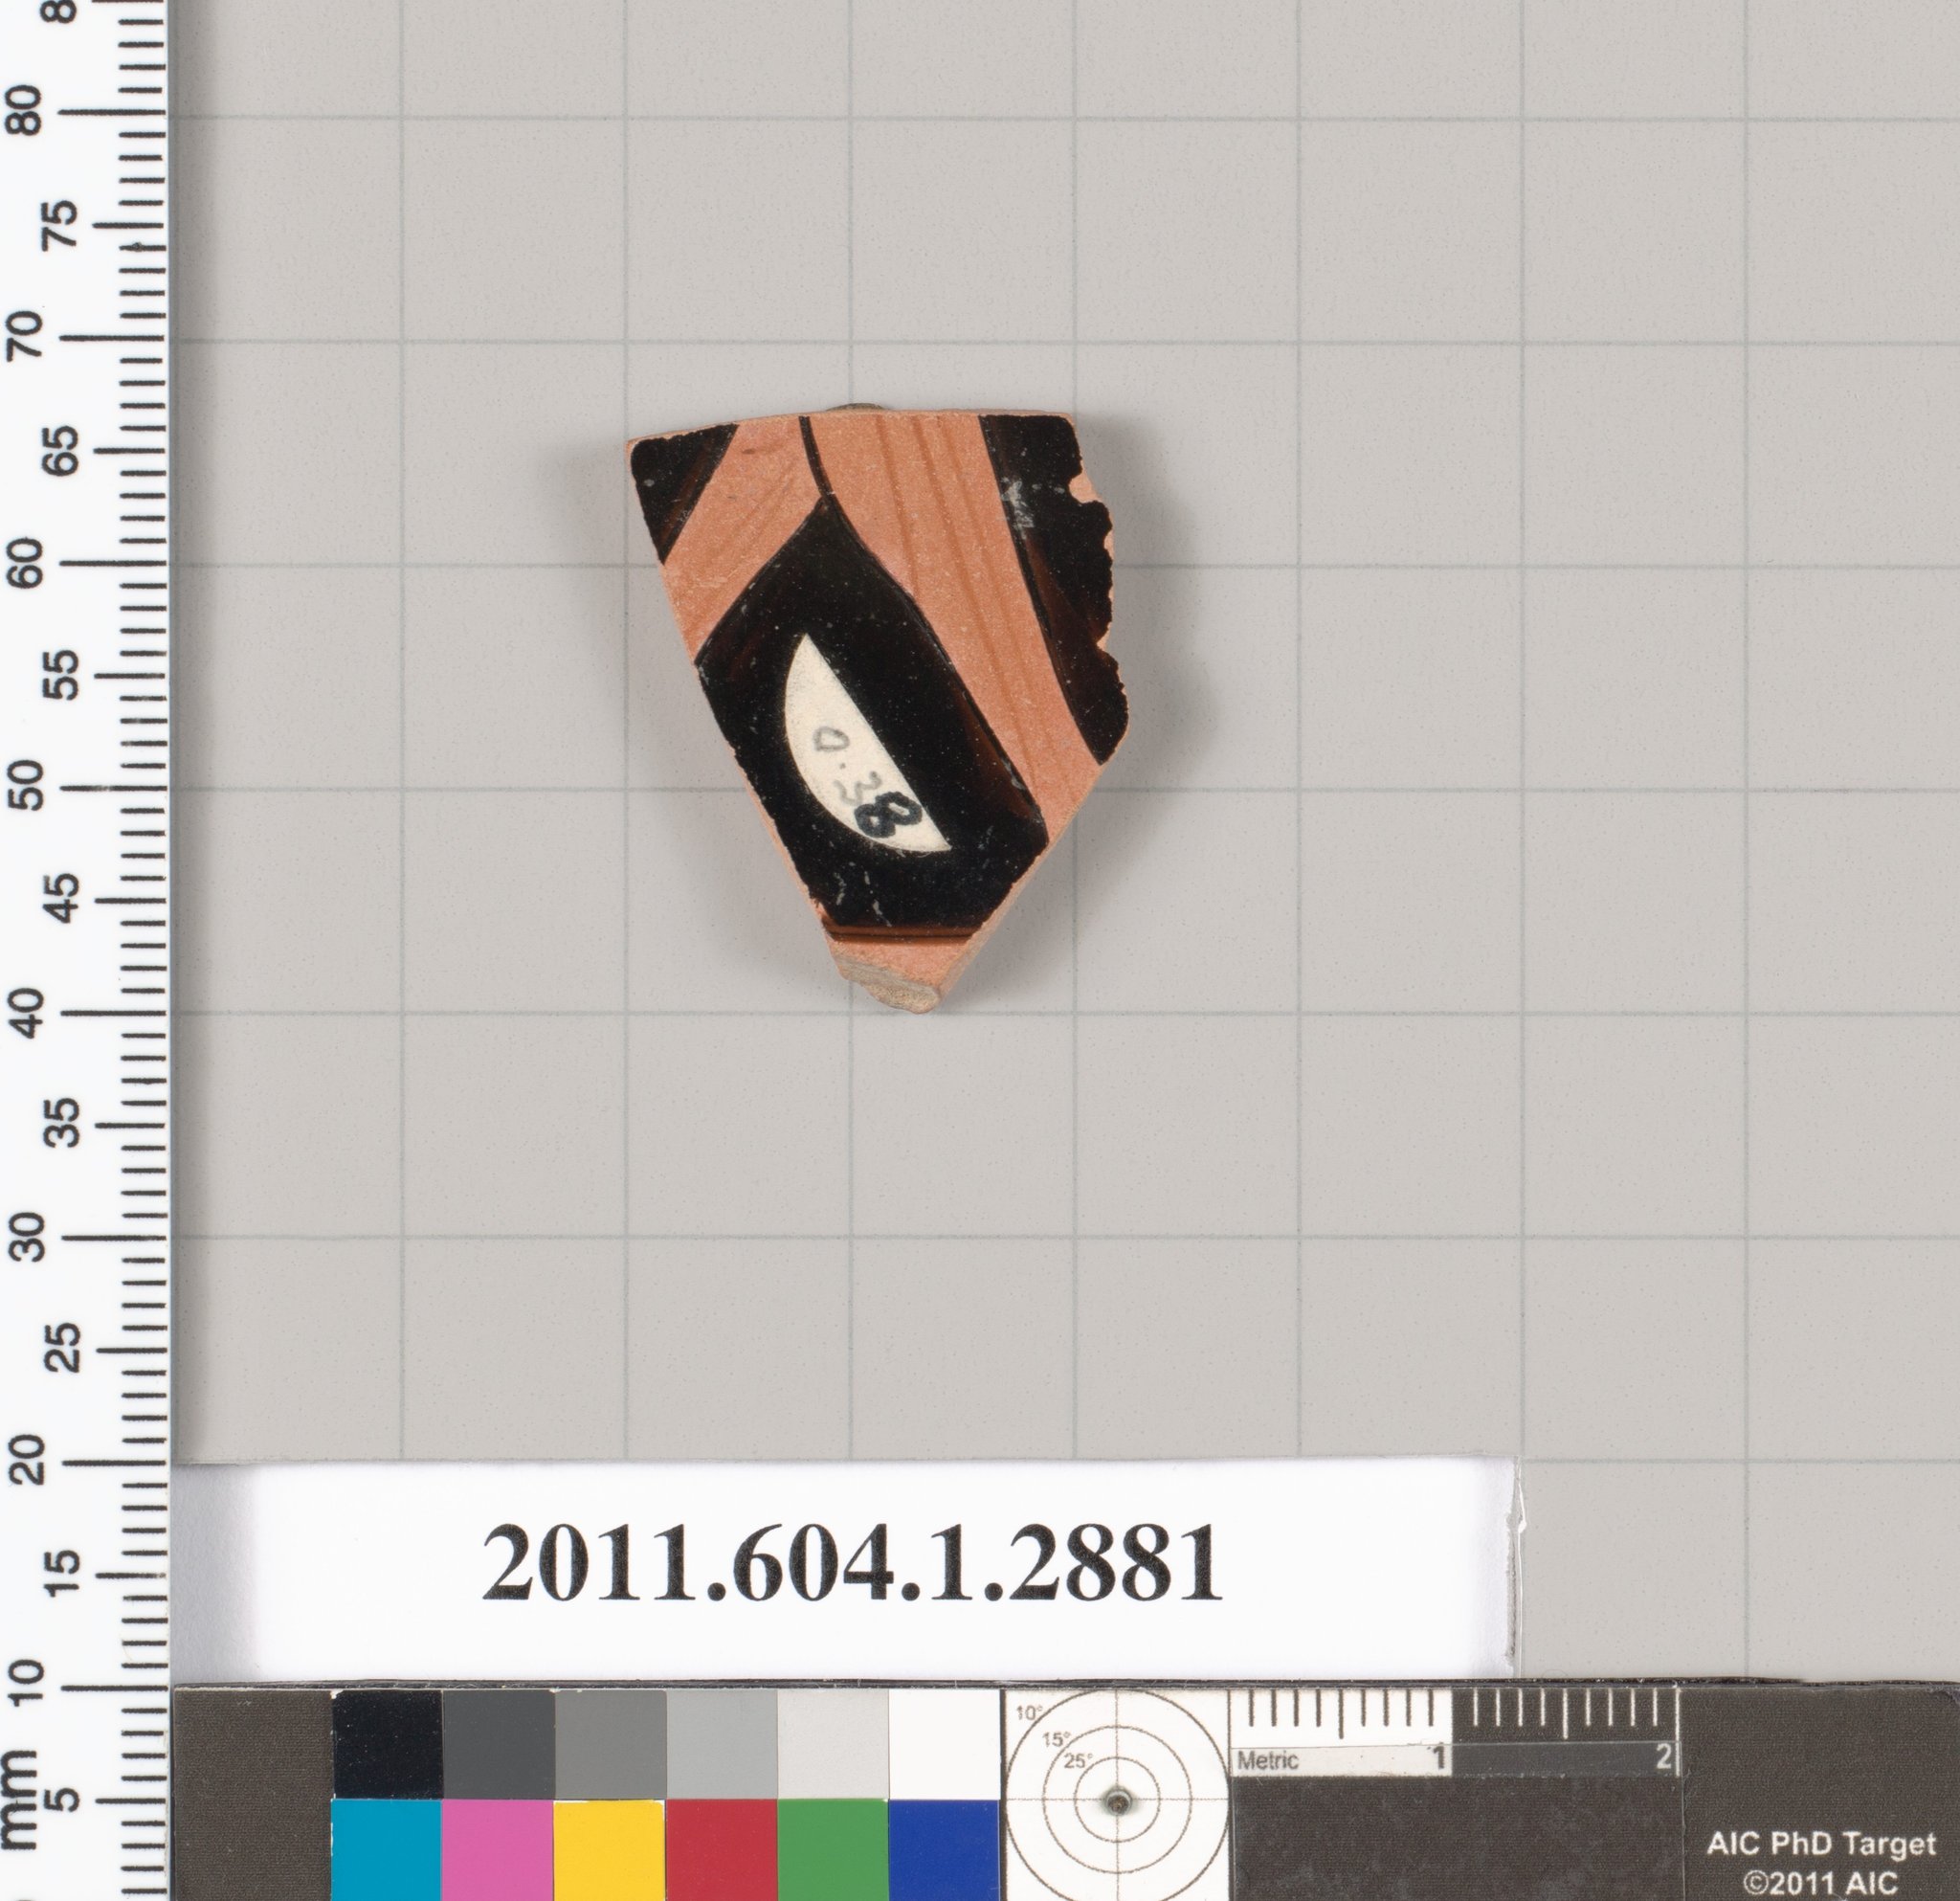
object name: kylix fragment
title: Terracotta fragment of a kylix (drinking cup)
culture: greek, attic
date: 500-490 BCE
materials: terracotta